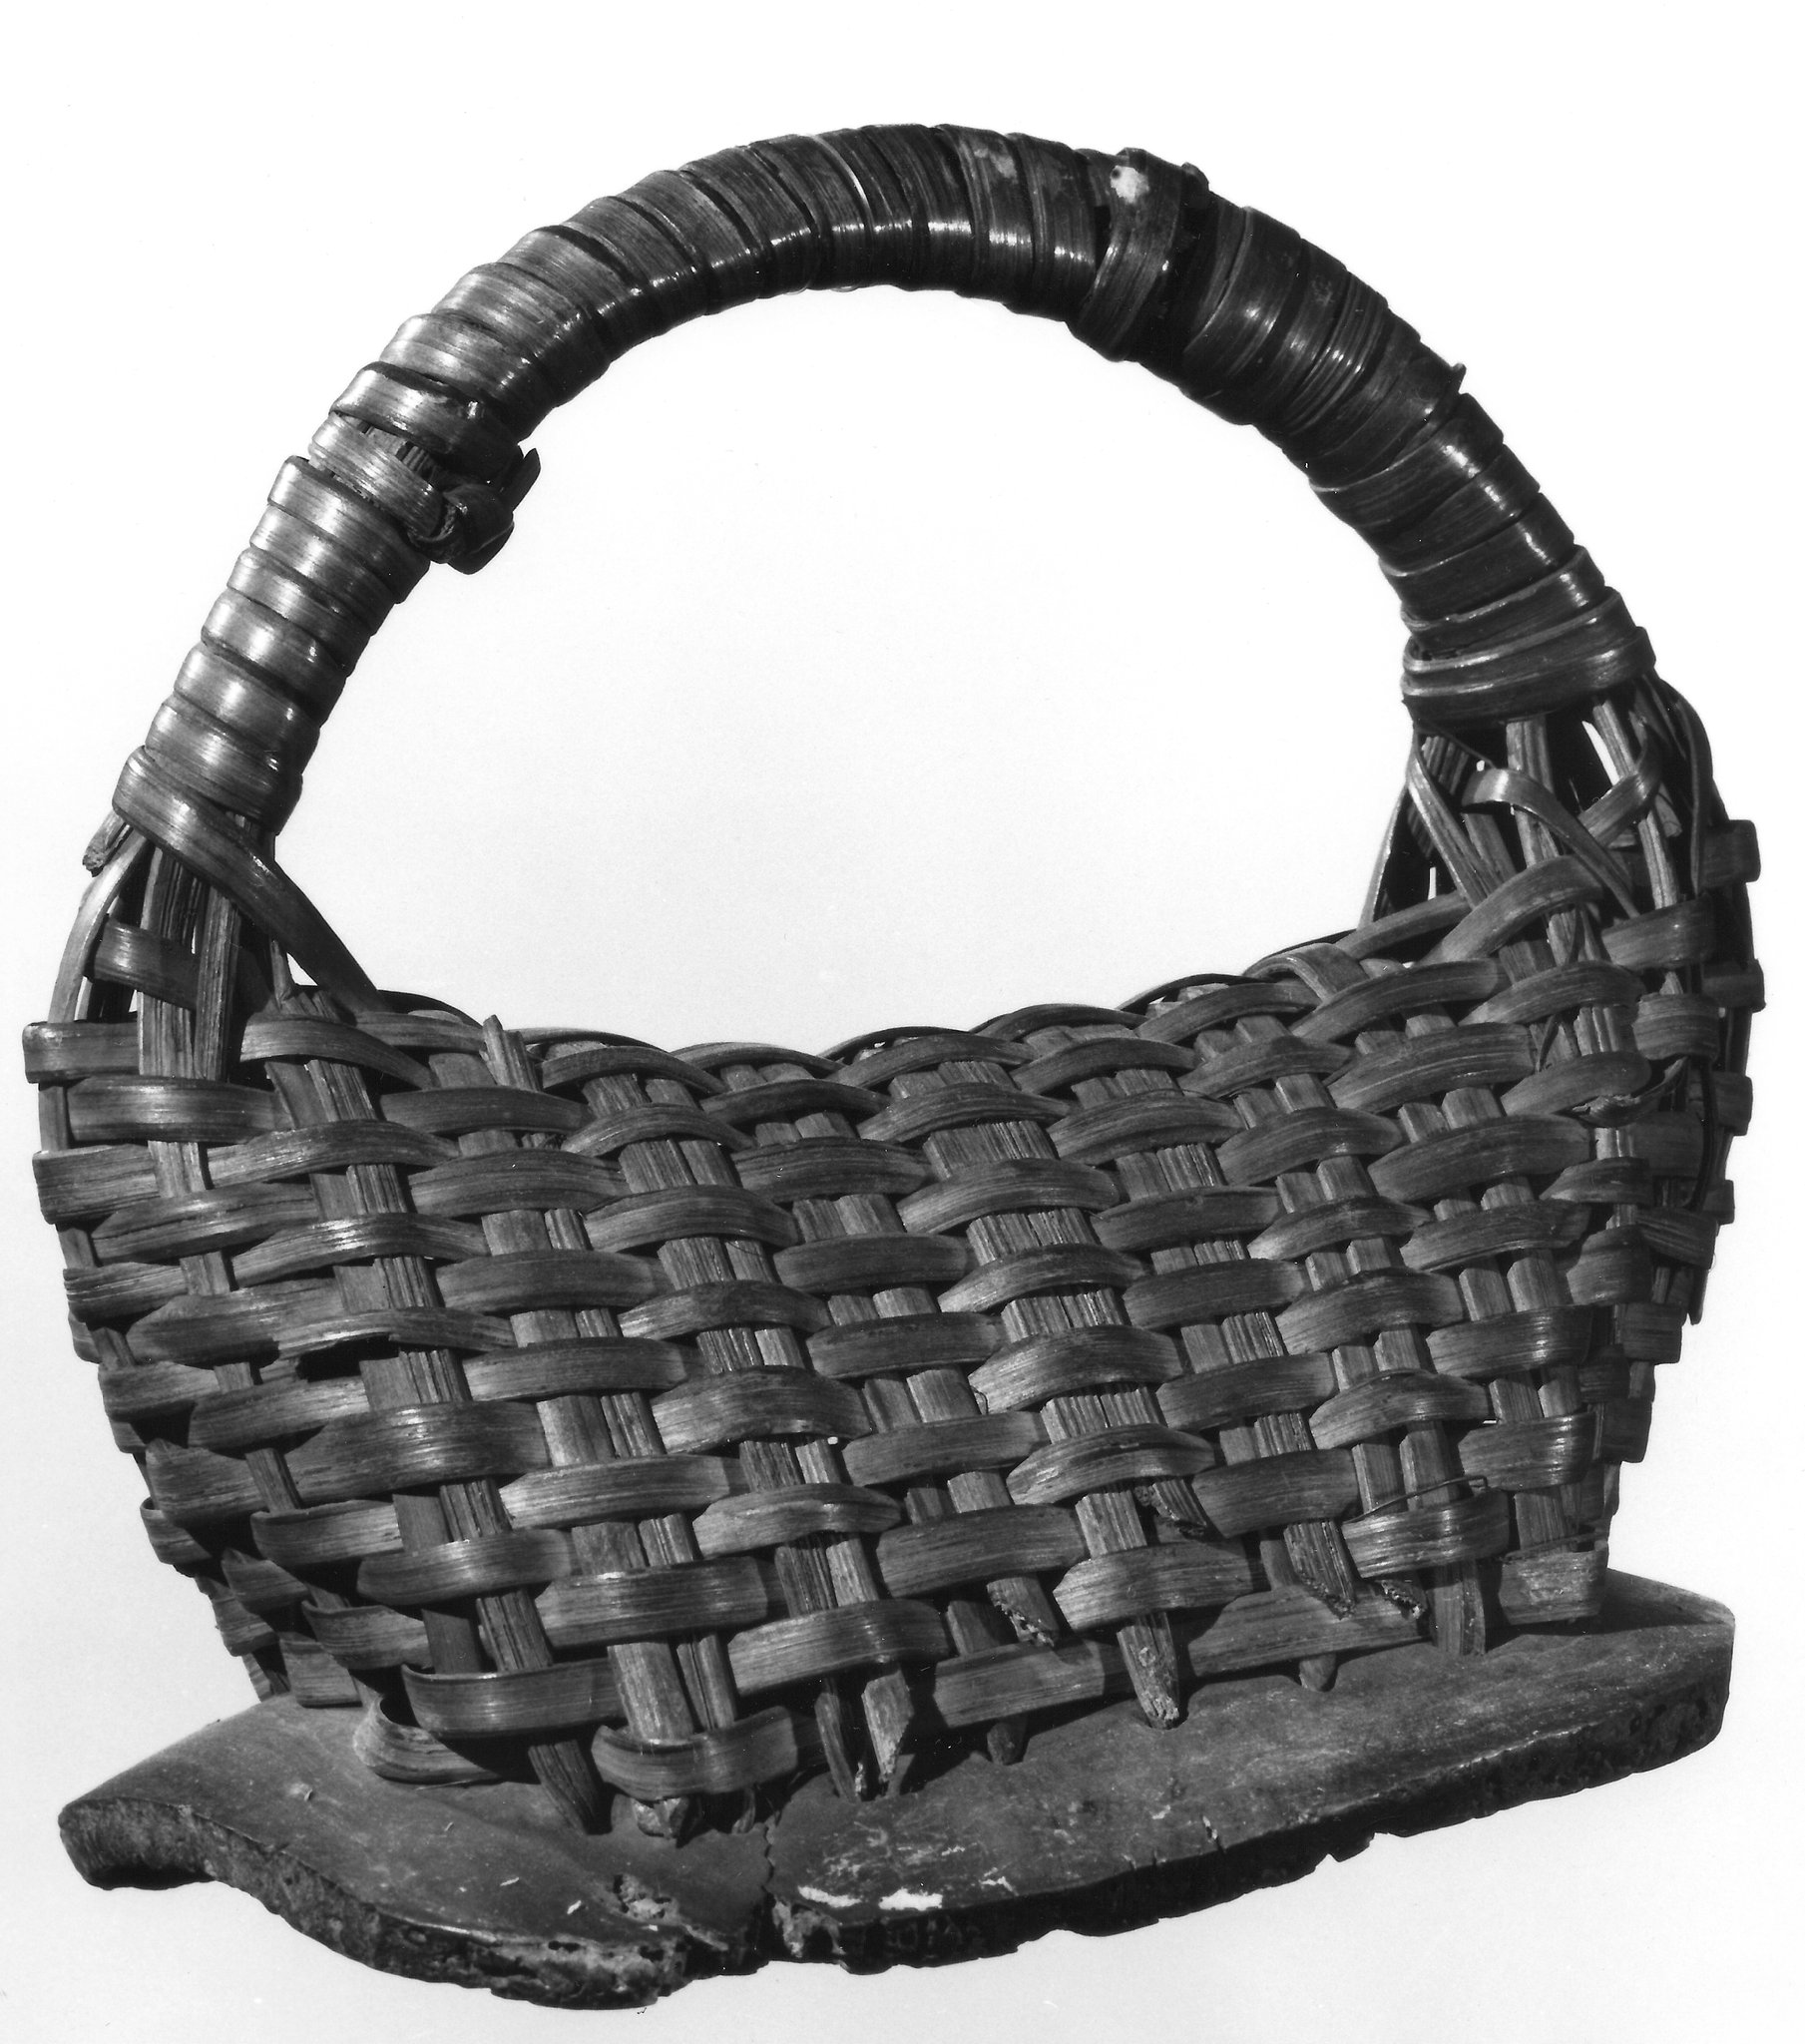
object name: rattle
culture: liberian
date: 1867-1900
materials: shell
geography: liberia